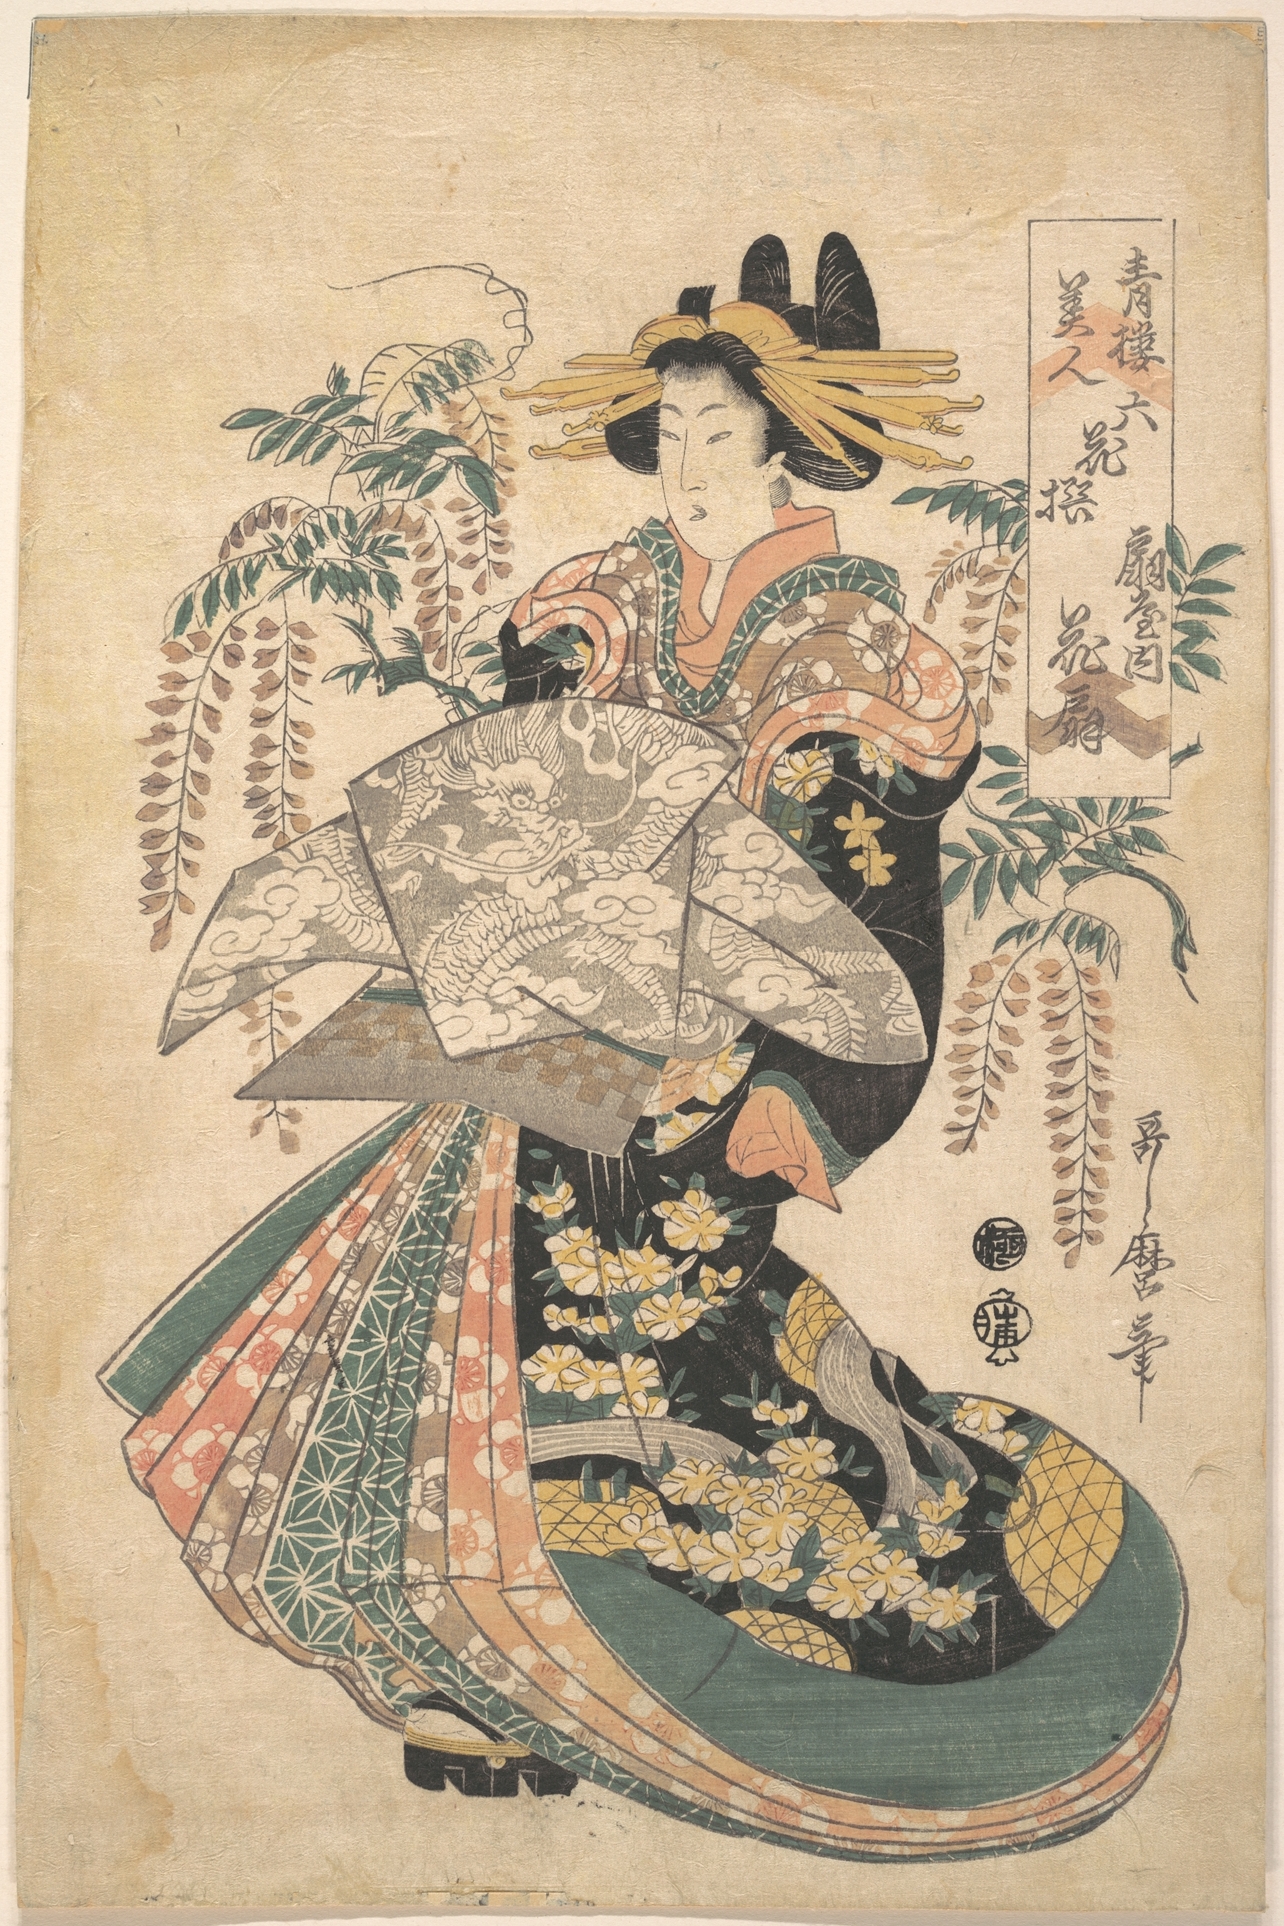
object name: print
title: A Courtesan with Wisteria on the Background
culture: japanese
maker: utamaro ii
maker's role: artist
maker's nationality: japanese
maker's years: 1750-1850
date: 1615-1831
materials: ink, paper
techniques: woodblock print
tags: women,flowers